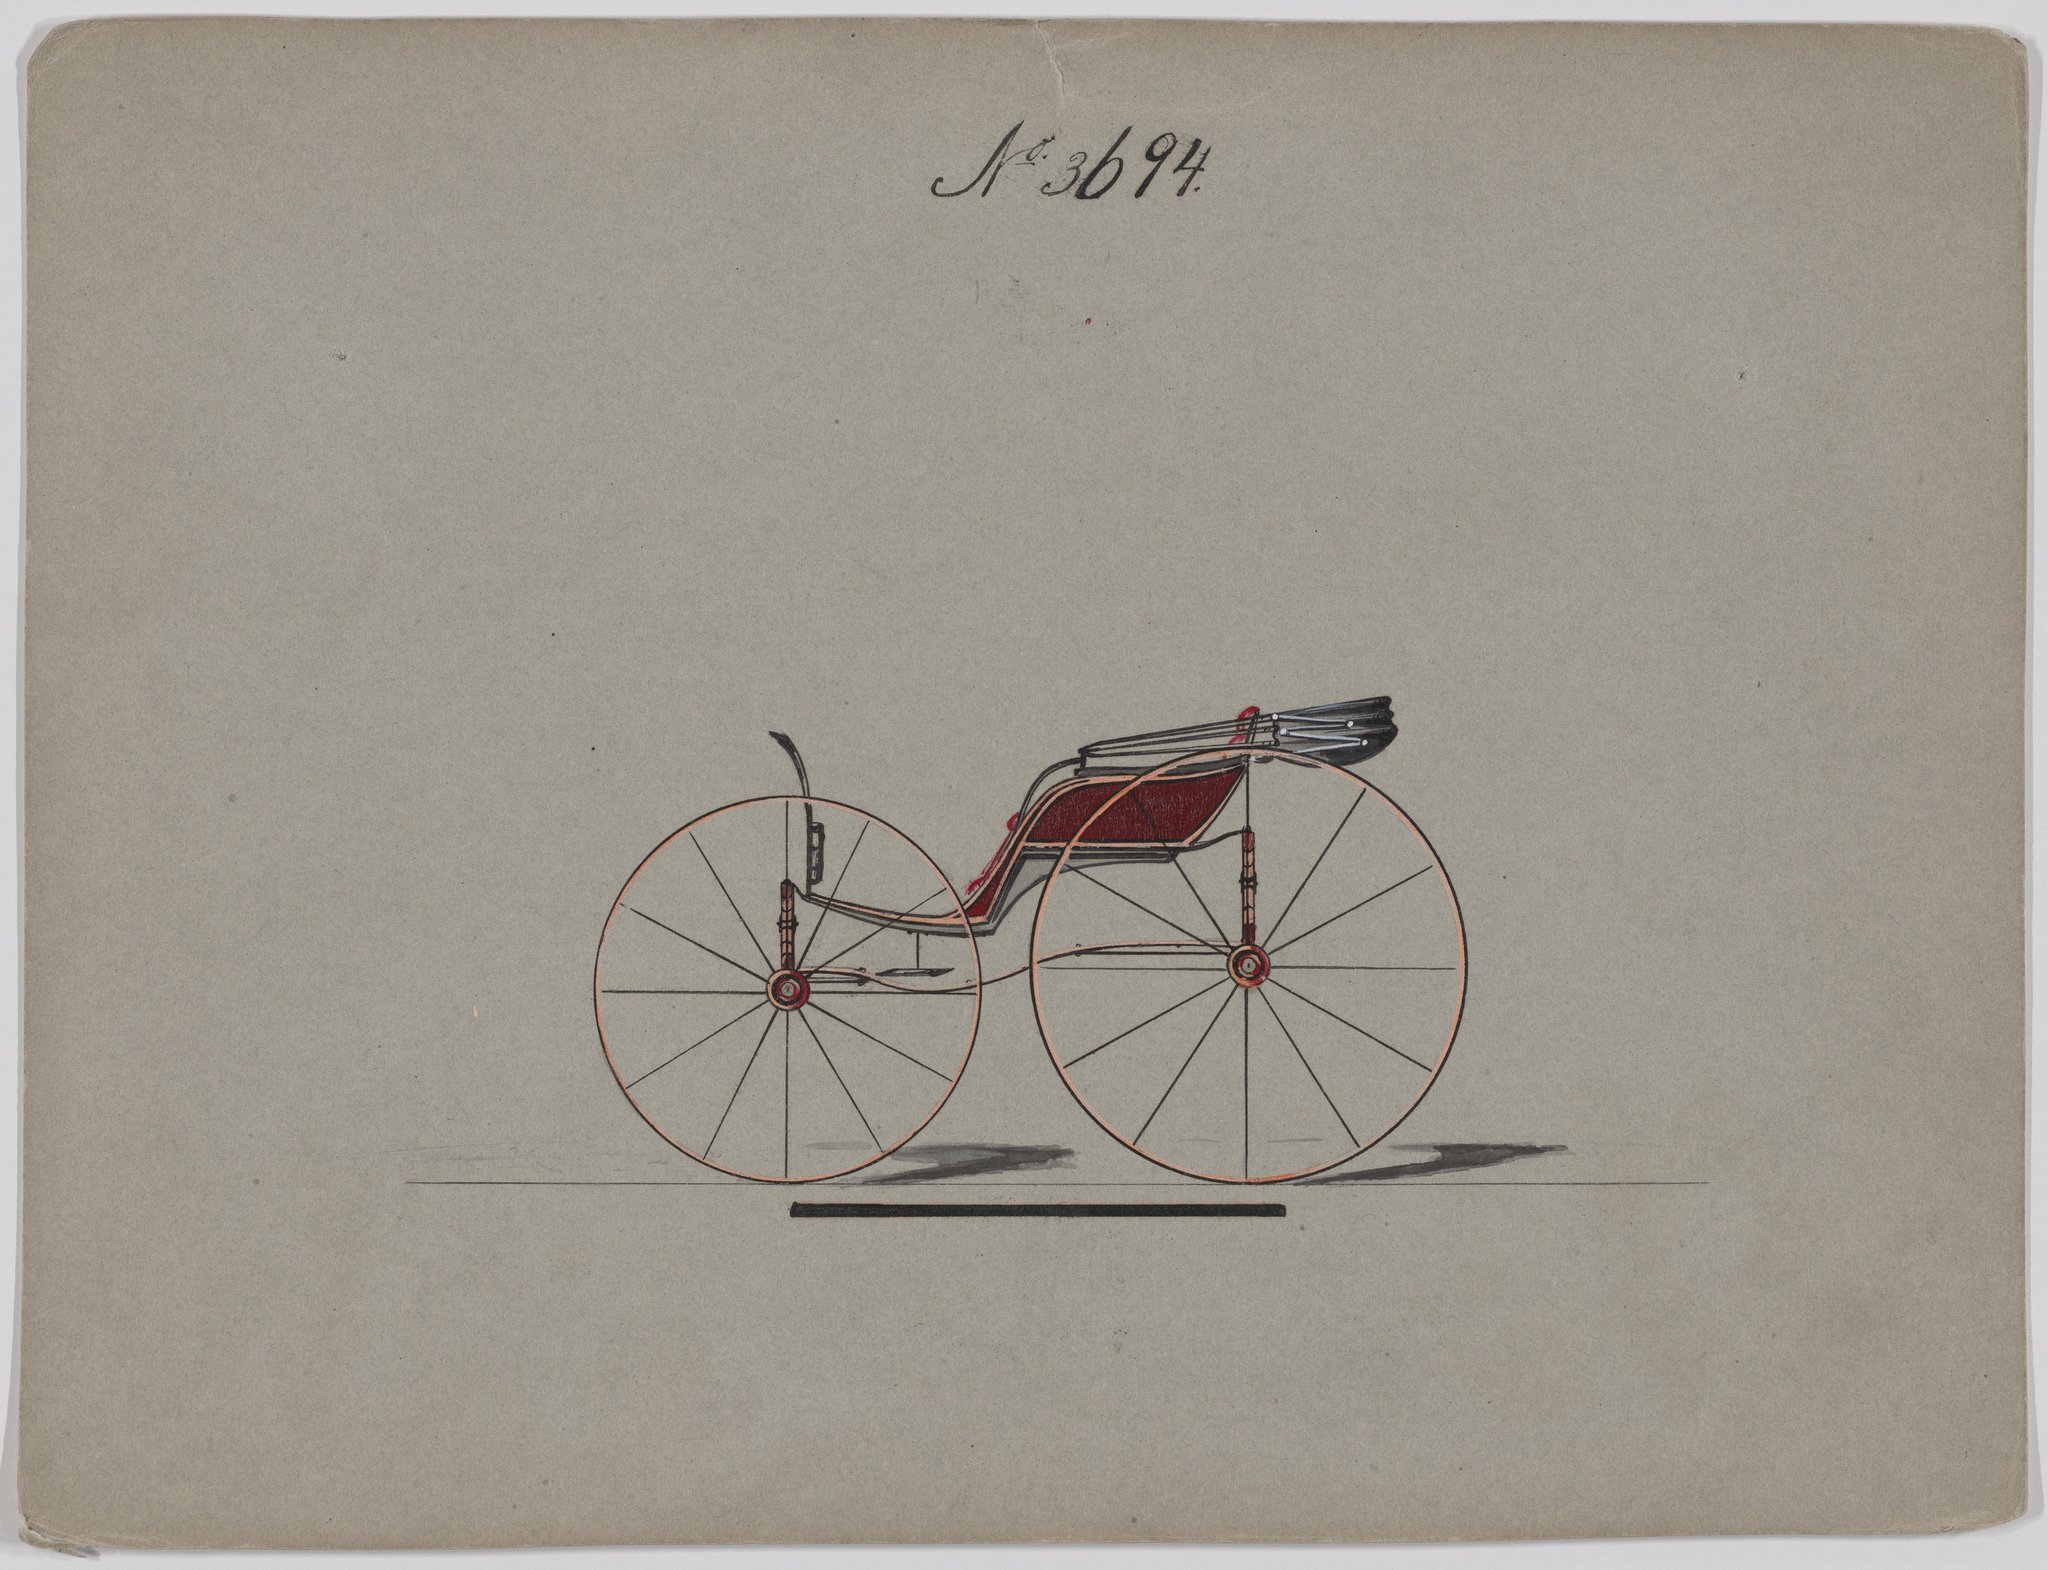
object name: drawing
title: Design for Pony Phaeton, no. 3694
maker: brewster & co.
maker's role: manufacturer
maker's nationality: american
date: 1881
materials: gouache, gum arabic, ink, watercolor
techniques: pen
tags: carriages